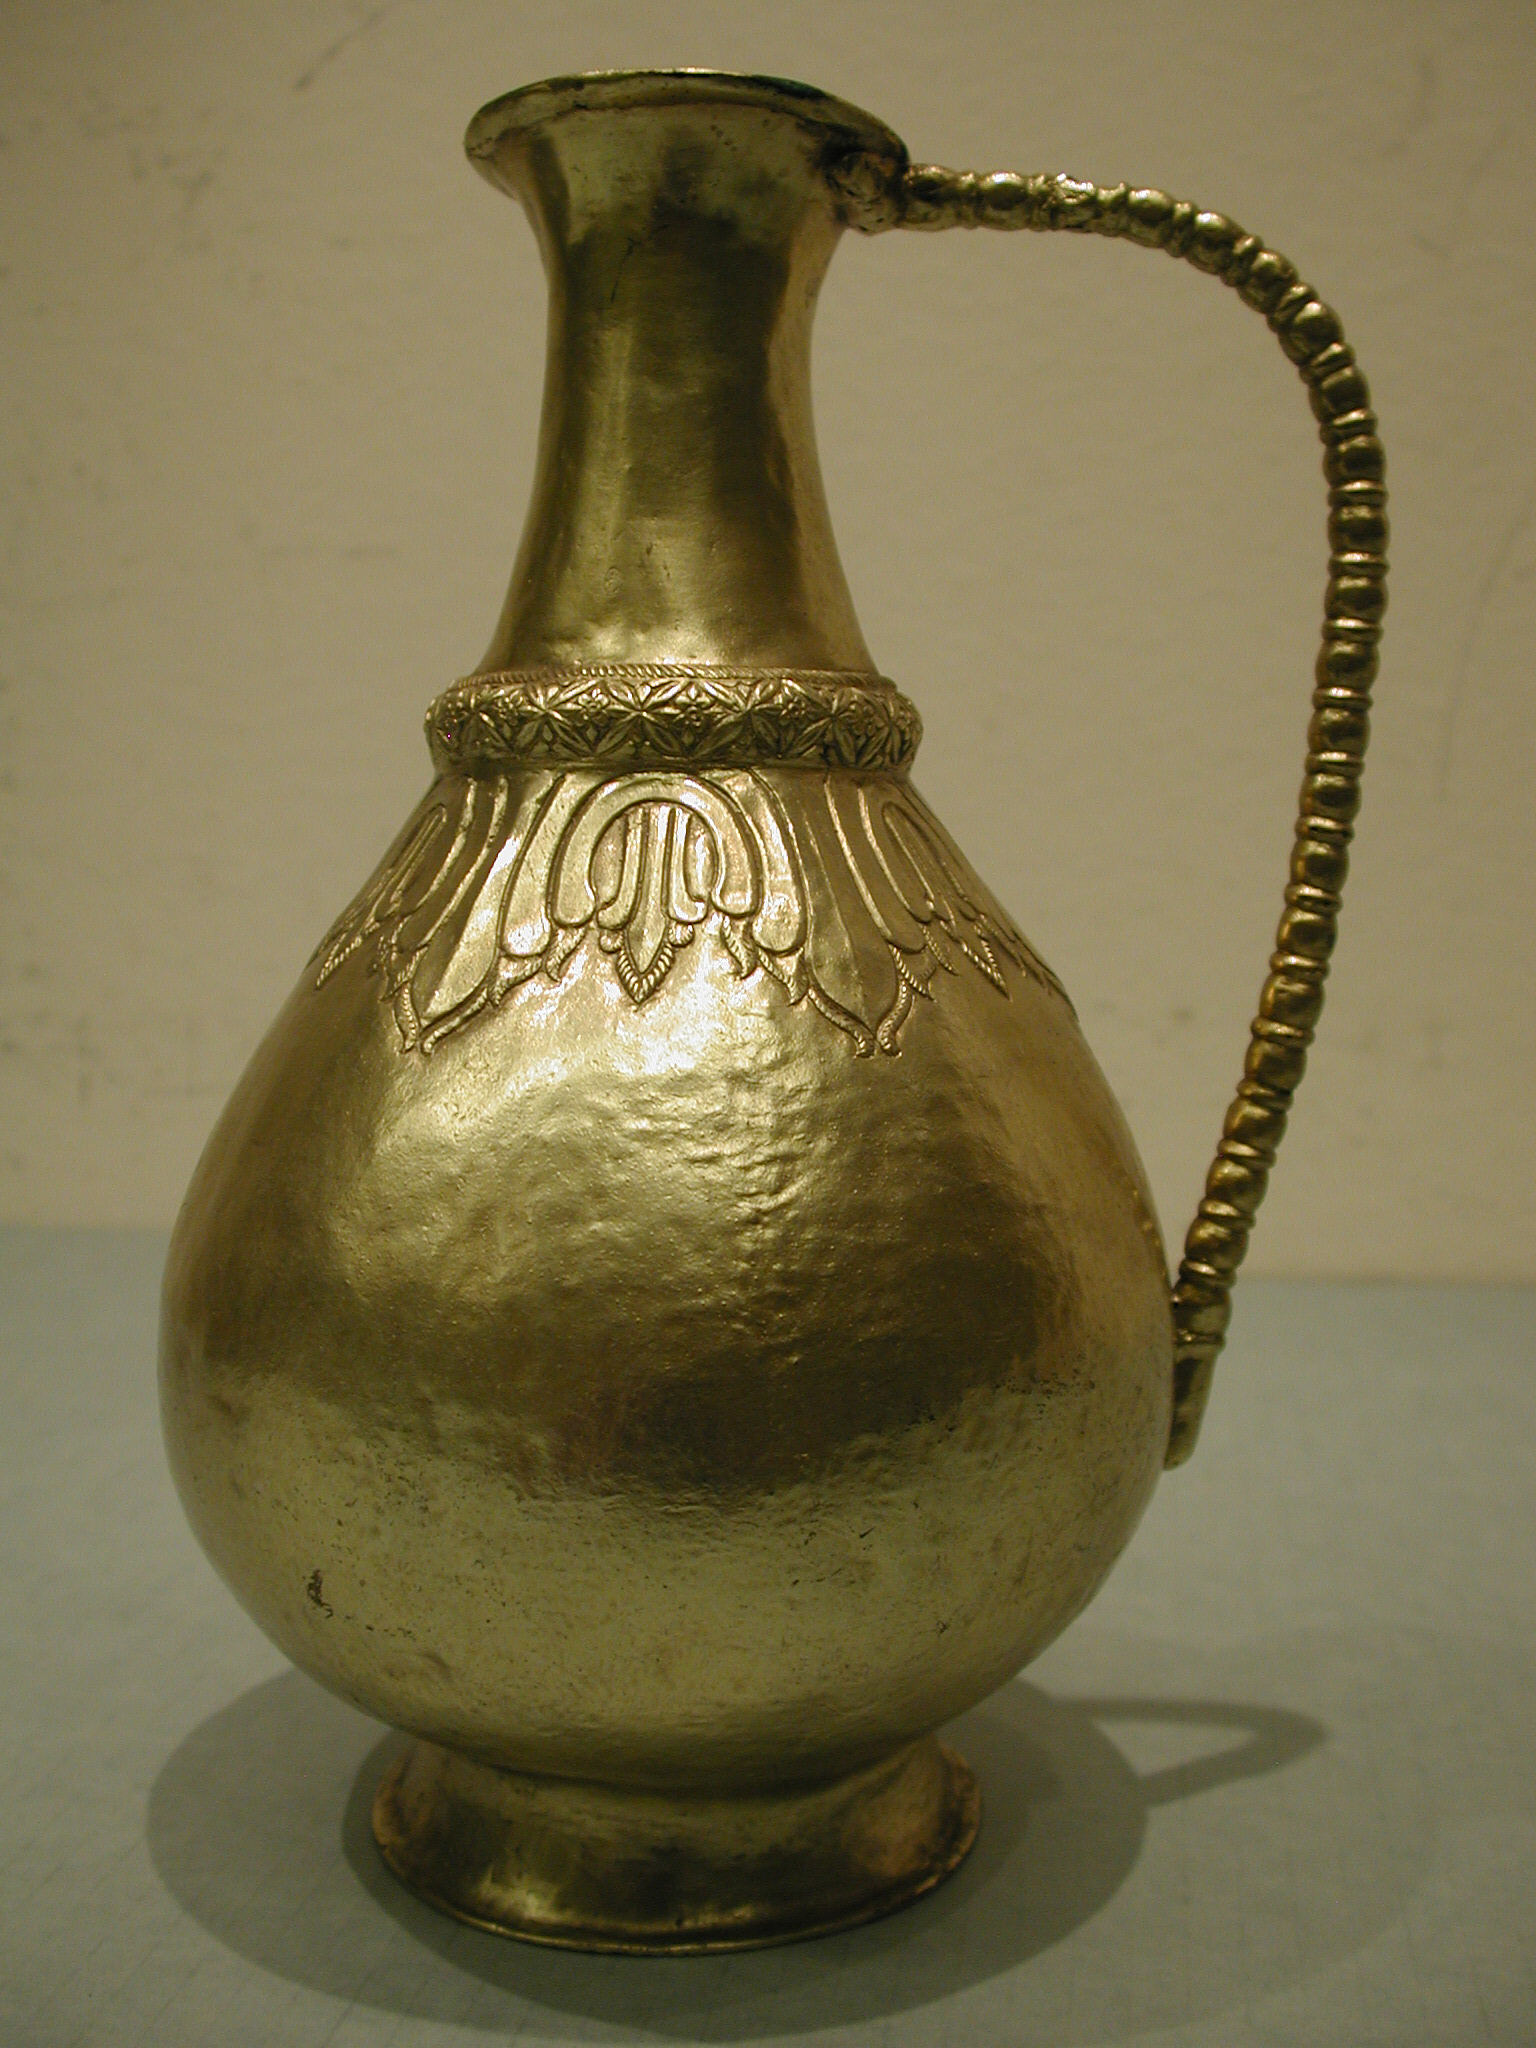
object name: ewer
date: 1801-1900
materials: metal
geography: hungary